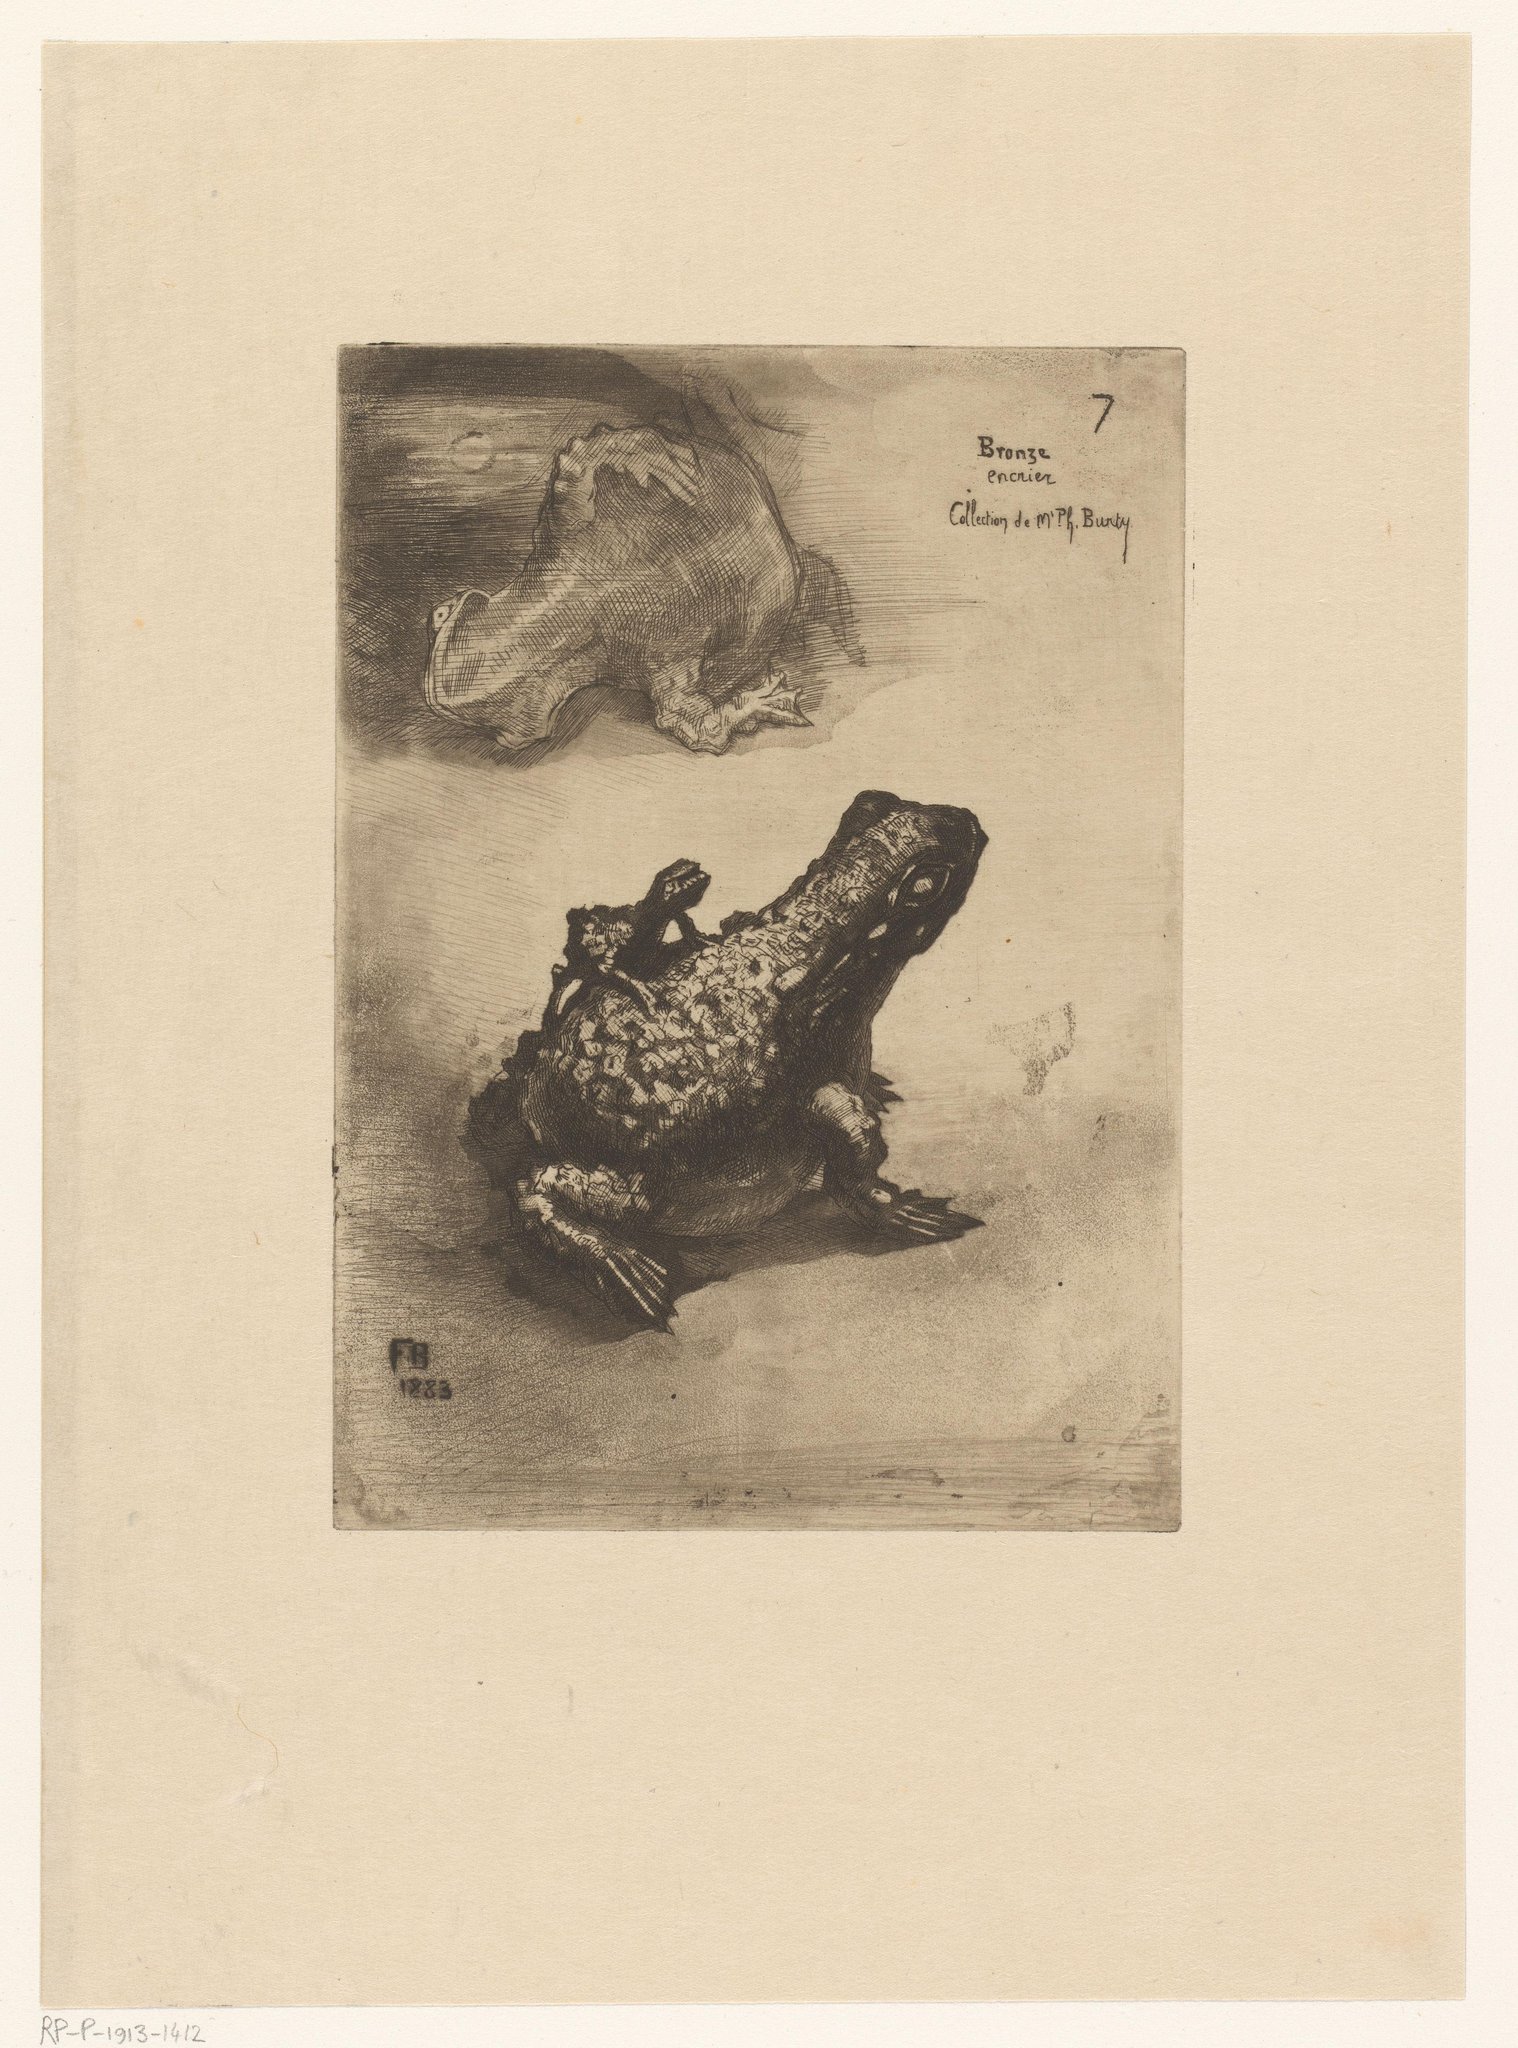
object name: print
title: Bronze encrier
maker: félix hilaire buhot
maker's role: draughtsman, print maker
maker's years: 1847-1898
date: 1883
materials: paper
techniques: aquatint, etching, intaglio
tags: tailless amphibians: toad, ink-well, piece of sculpture, reproduction of a piece of sculpture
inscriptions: collector's mark: Lugt 2233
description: Prent uit een serie bestaande uit acht platen plus titelprent en ex libris, naar Japanse objecten uit de collectie van Philippe Burty, uitgegeven in Parijs door Edmond Sagot in (april) 1883. In dat jaar vond er een belangrijke tentoonstelling plaats evenals andere Japan-georiënteerde activiteiten. Op 10 april 1883 opende de eerste retrospectieve tentoonstelling van Japanse kunst in de Westerse wereld in de Gallery Georges Petit op de Rue de Sèze te Parijs. Volgens een brief van Buhot aan Octave Uzanne, gedateerd 4 april 1883, had Buhot in 1875 reeds negen van de tien platen vervaardigd. Bourcard & Goodfriend vermelden dat er van de serie vijftig waren gedrukt op Japans papier, honderd op Nederlands papier en enkelen op geel met goud bewerkt papier.